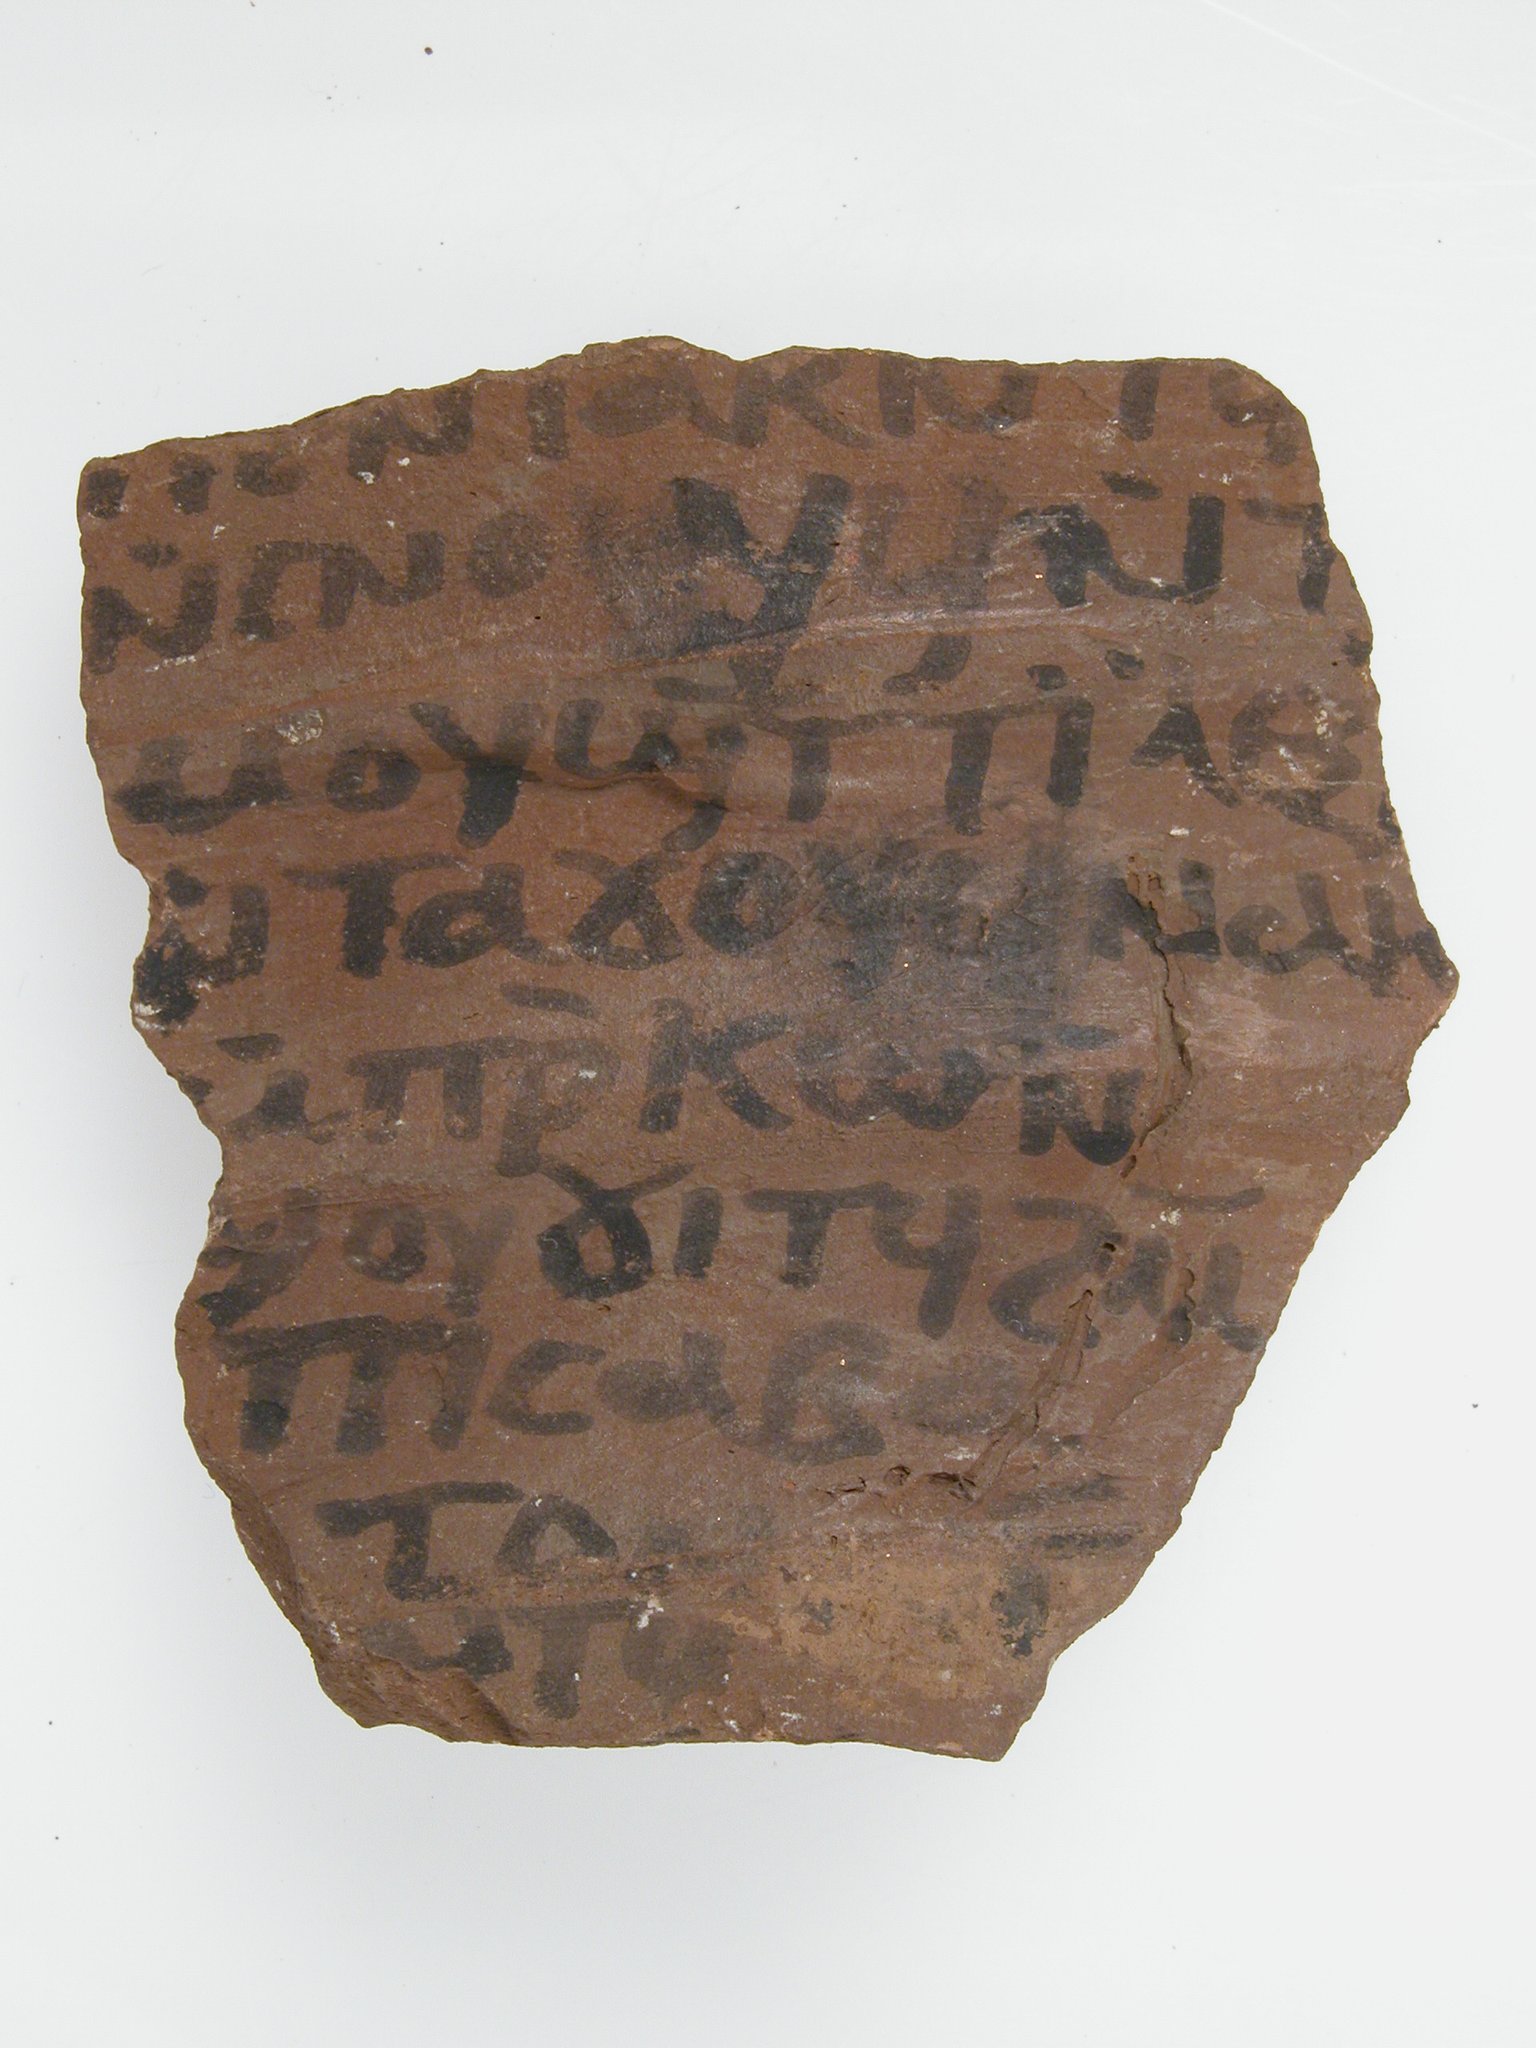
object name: ostrakon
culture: coptic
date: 601-700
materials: ink, pottery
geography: egypt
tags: coptic